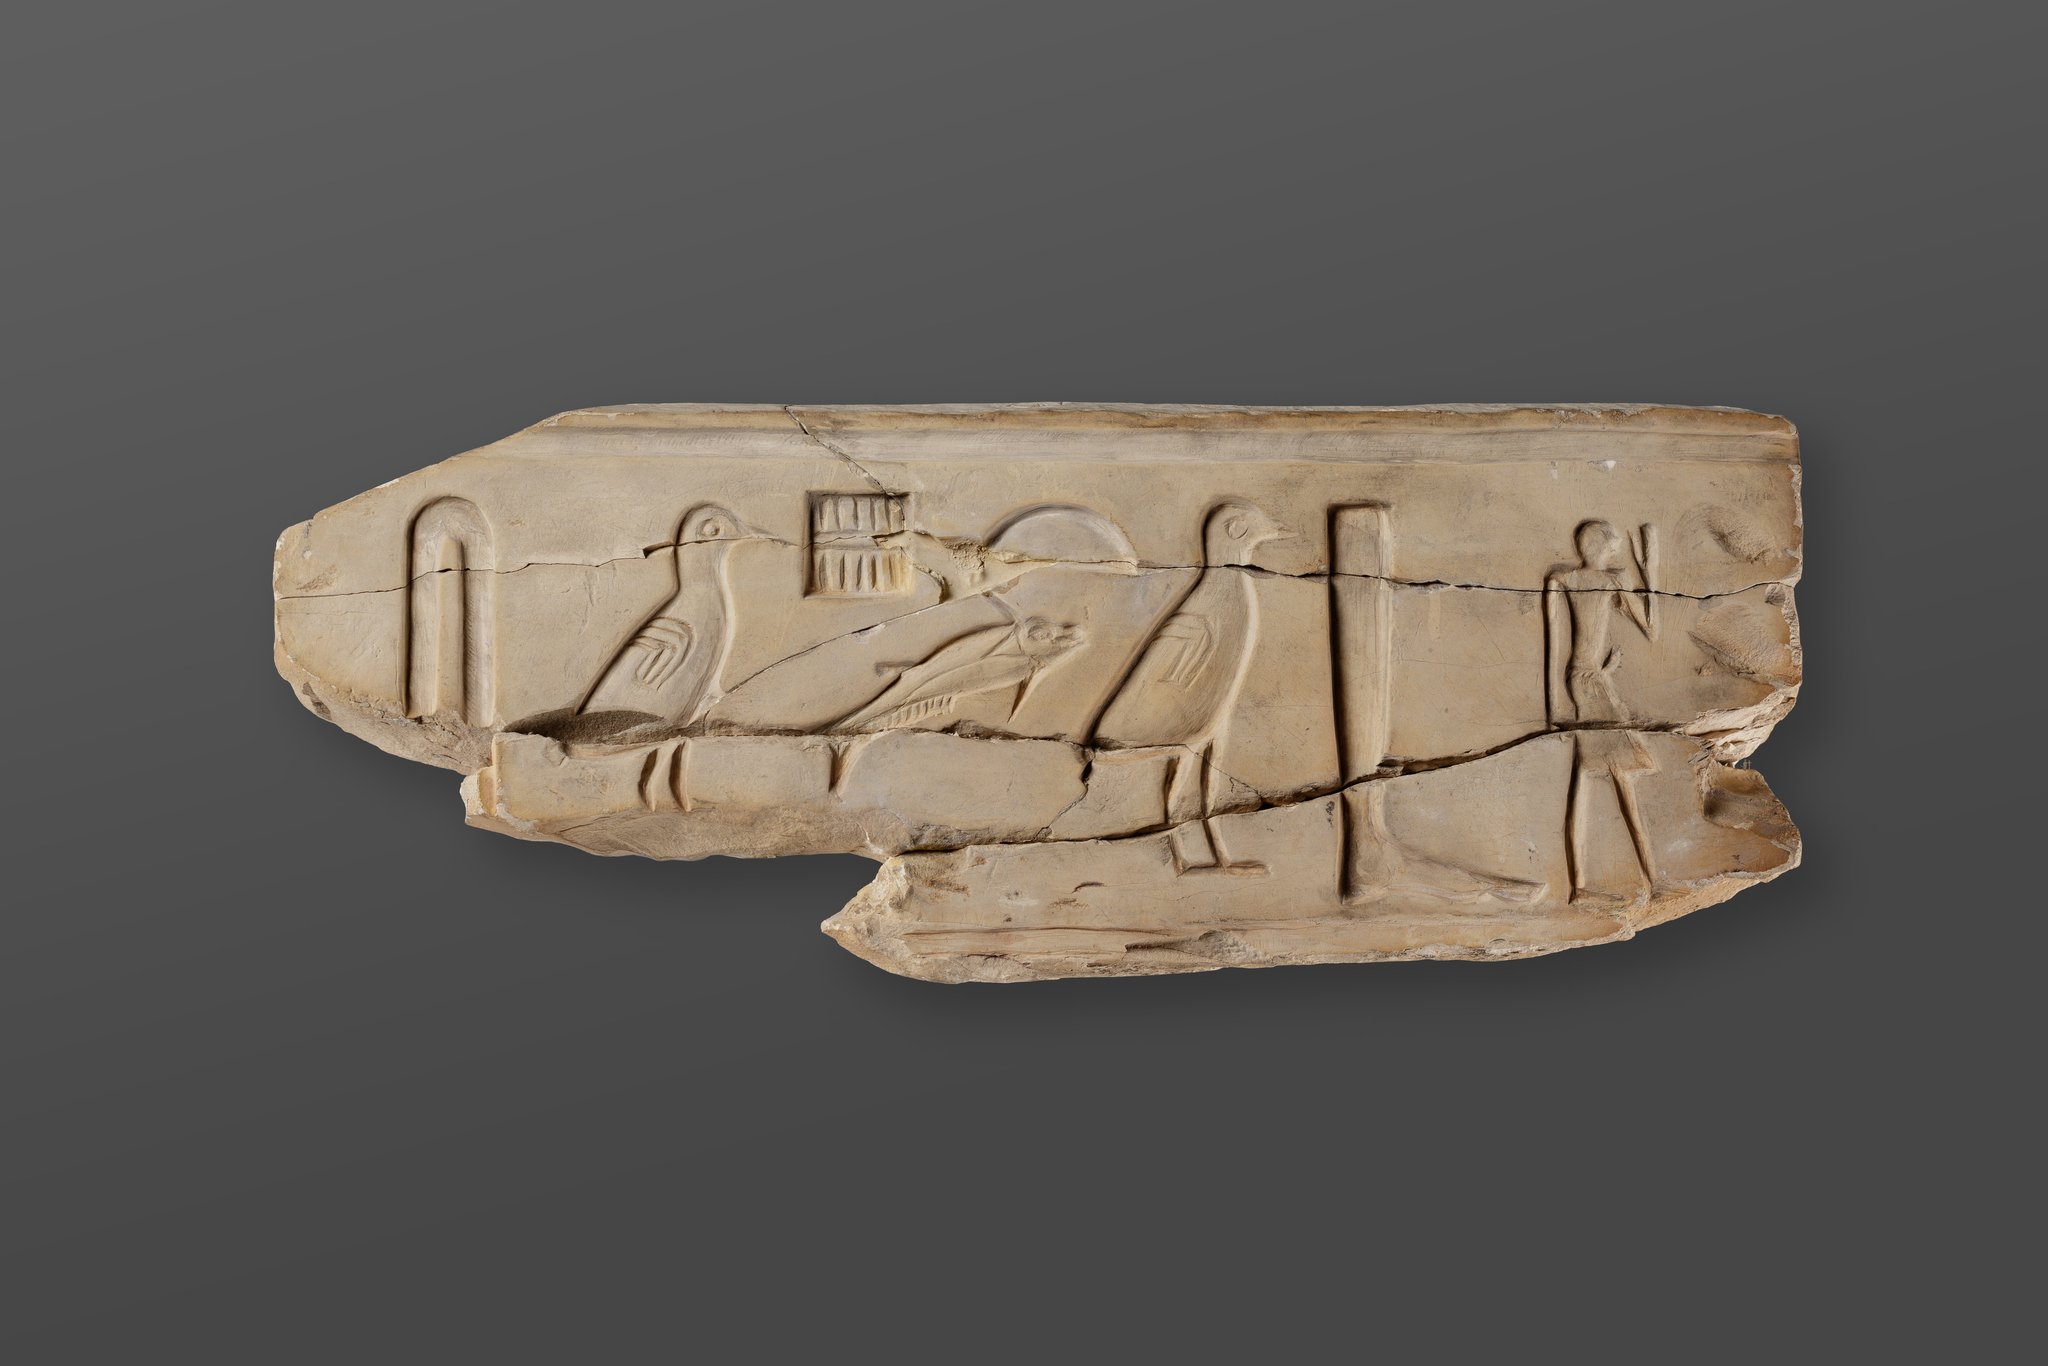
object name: relief fragment, tomb of mereri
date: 2100-2030 BCE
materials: limestone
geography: egypt